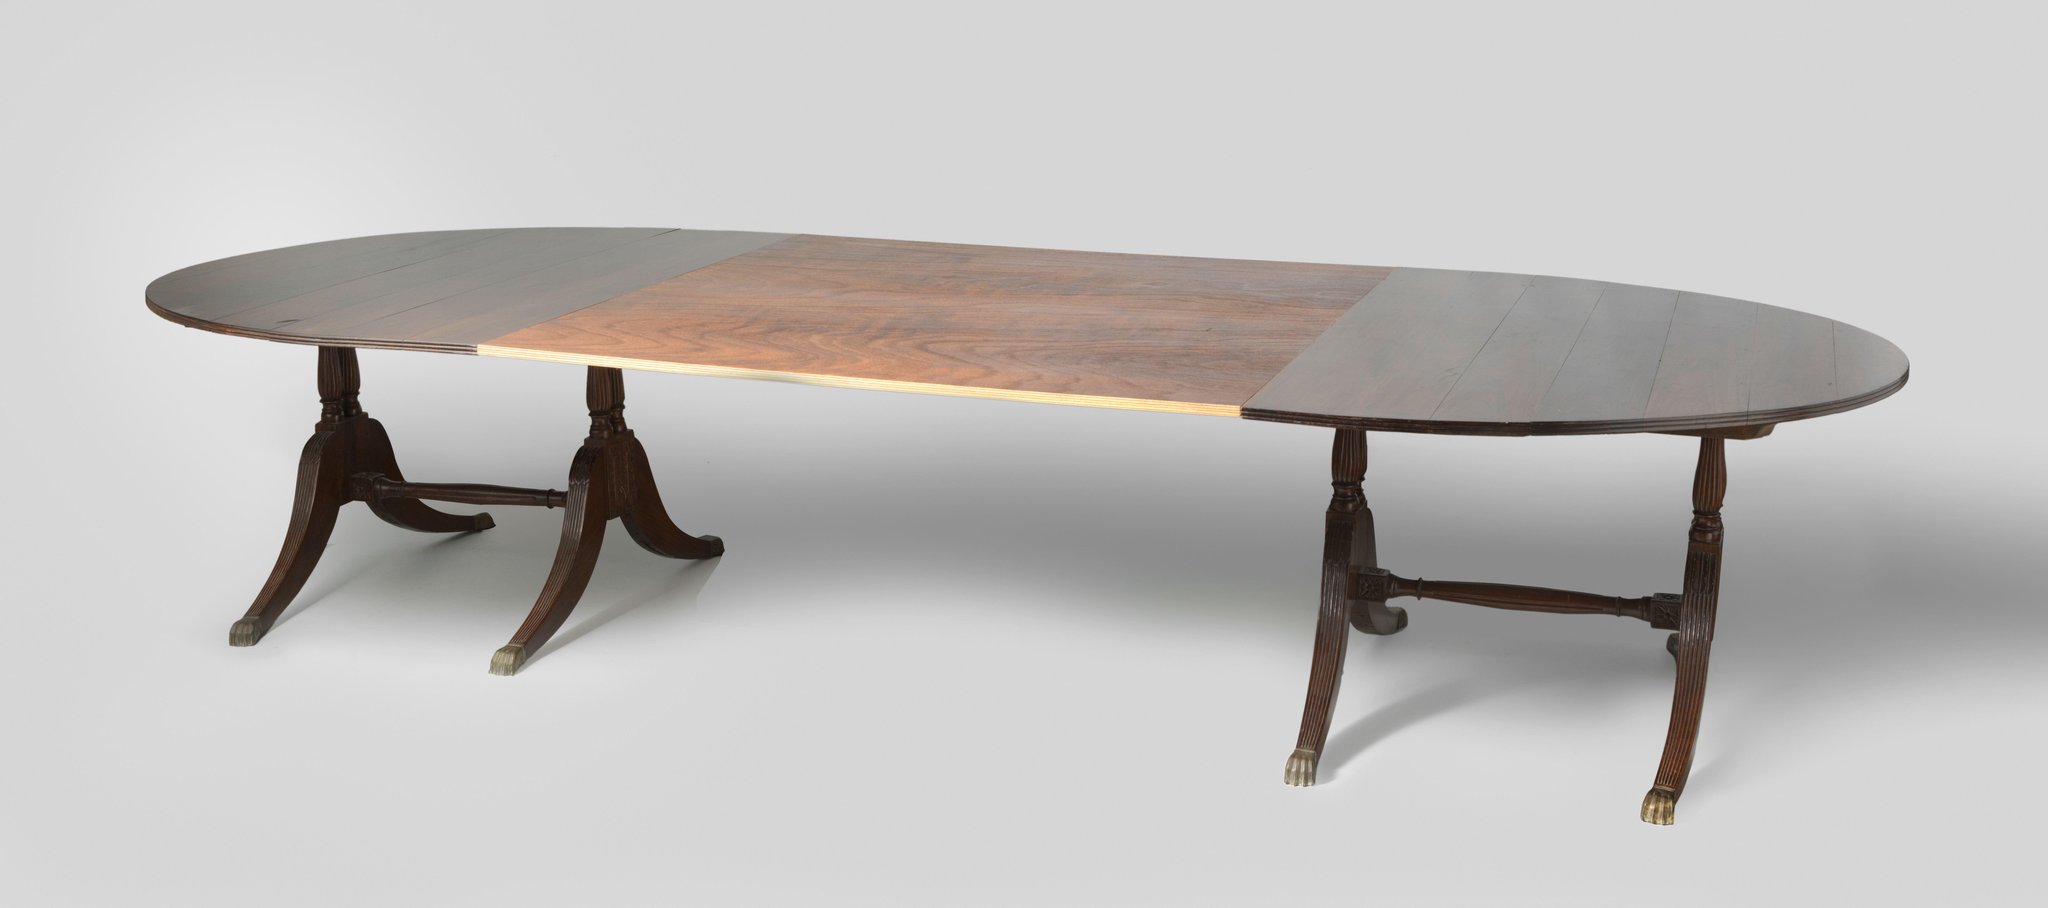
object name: furniture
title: Halve tafel met ovaal blad en schraagvormige poten die eindigen in klauwen van koper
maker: Anonymous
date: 1800-1815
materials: copper, wood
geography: dutch east indies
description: Grote tafel van ijzerhout met een ovaal blad dat uit twee delen bestaat. De poten bestaan uit vier schraagvormige steunen, eindigend in koperen klauwen; ieder der steunen draagt twee gecanneleerde korte zuilen, waar het blad op steunt. De steunen worden paarsgewijs verbonden door een gelede zuilvormige dwarsregel, geplaatst tussen huizen versierd met rozetten.